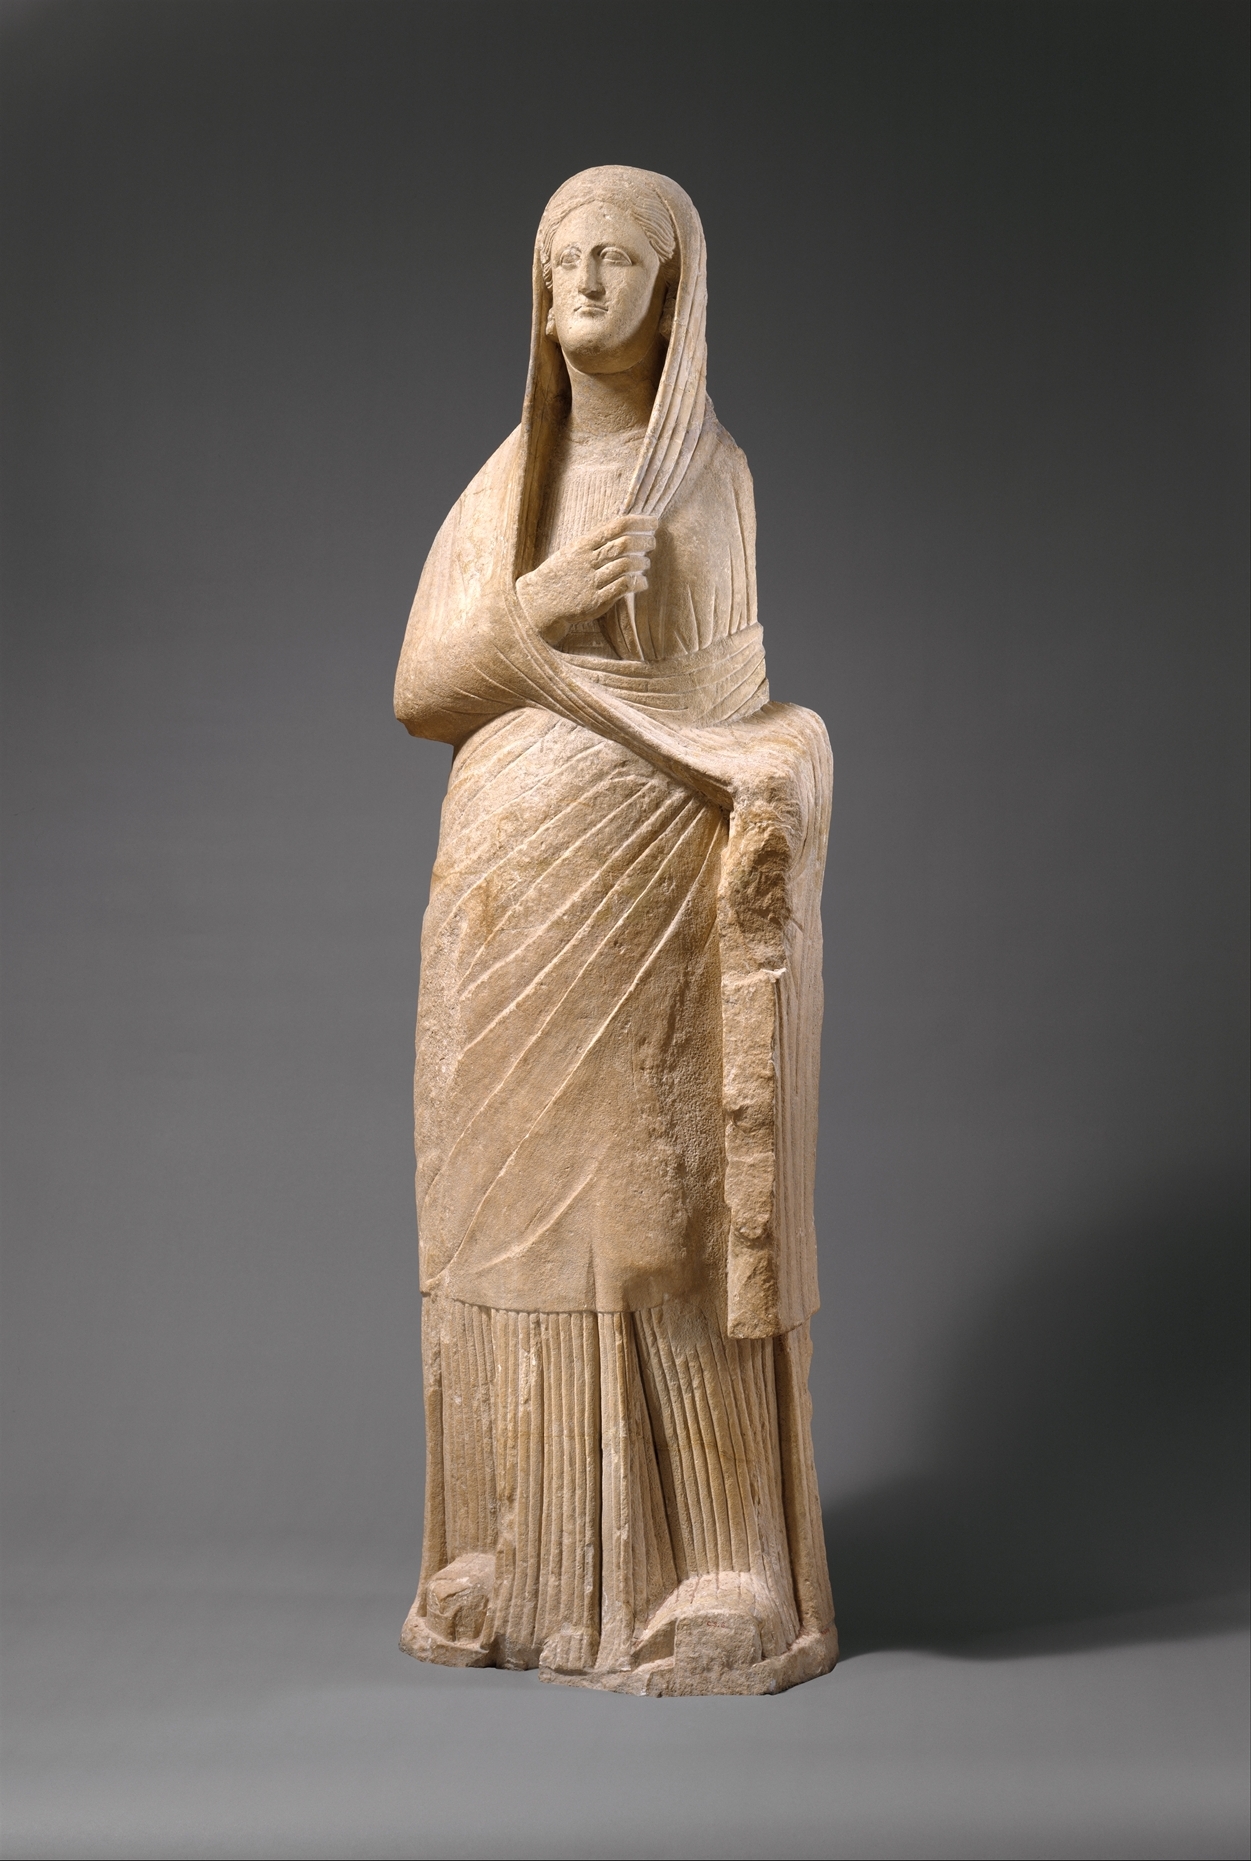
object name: statue of a woman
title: Limestone statue of a veiled female votary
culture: cypriot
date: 100-1 BCE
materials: limestone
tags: women